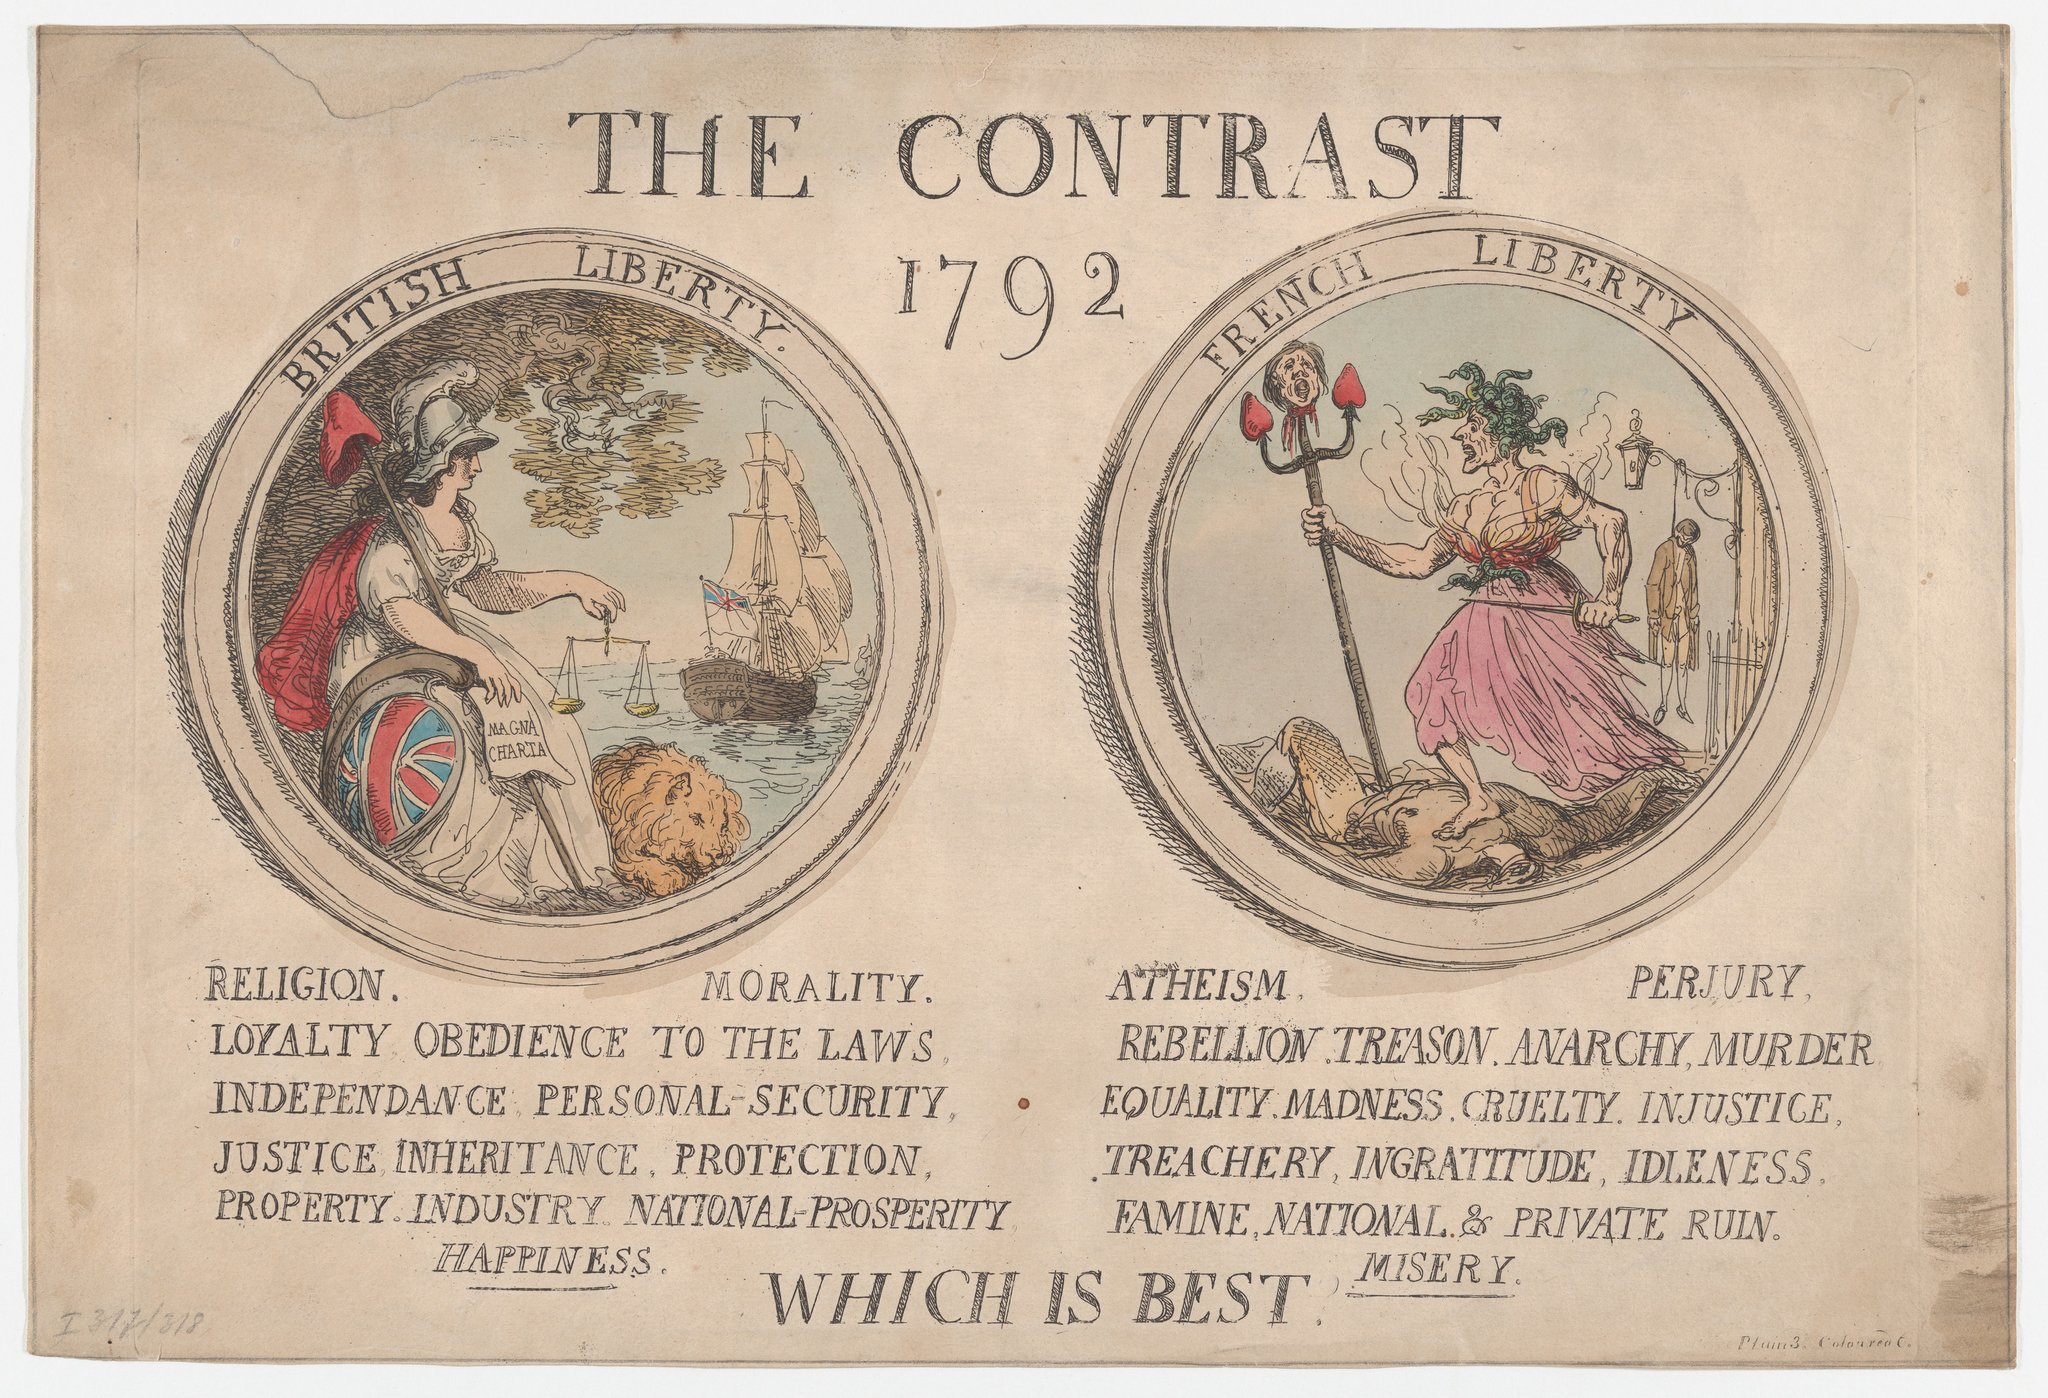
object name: print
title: The Contrast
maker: thomas rowlandson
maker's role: artist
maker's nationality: british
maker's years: 1757-1827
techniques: etching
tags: devil,goddess,boats